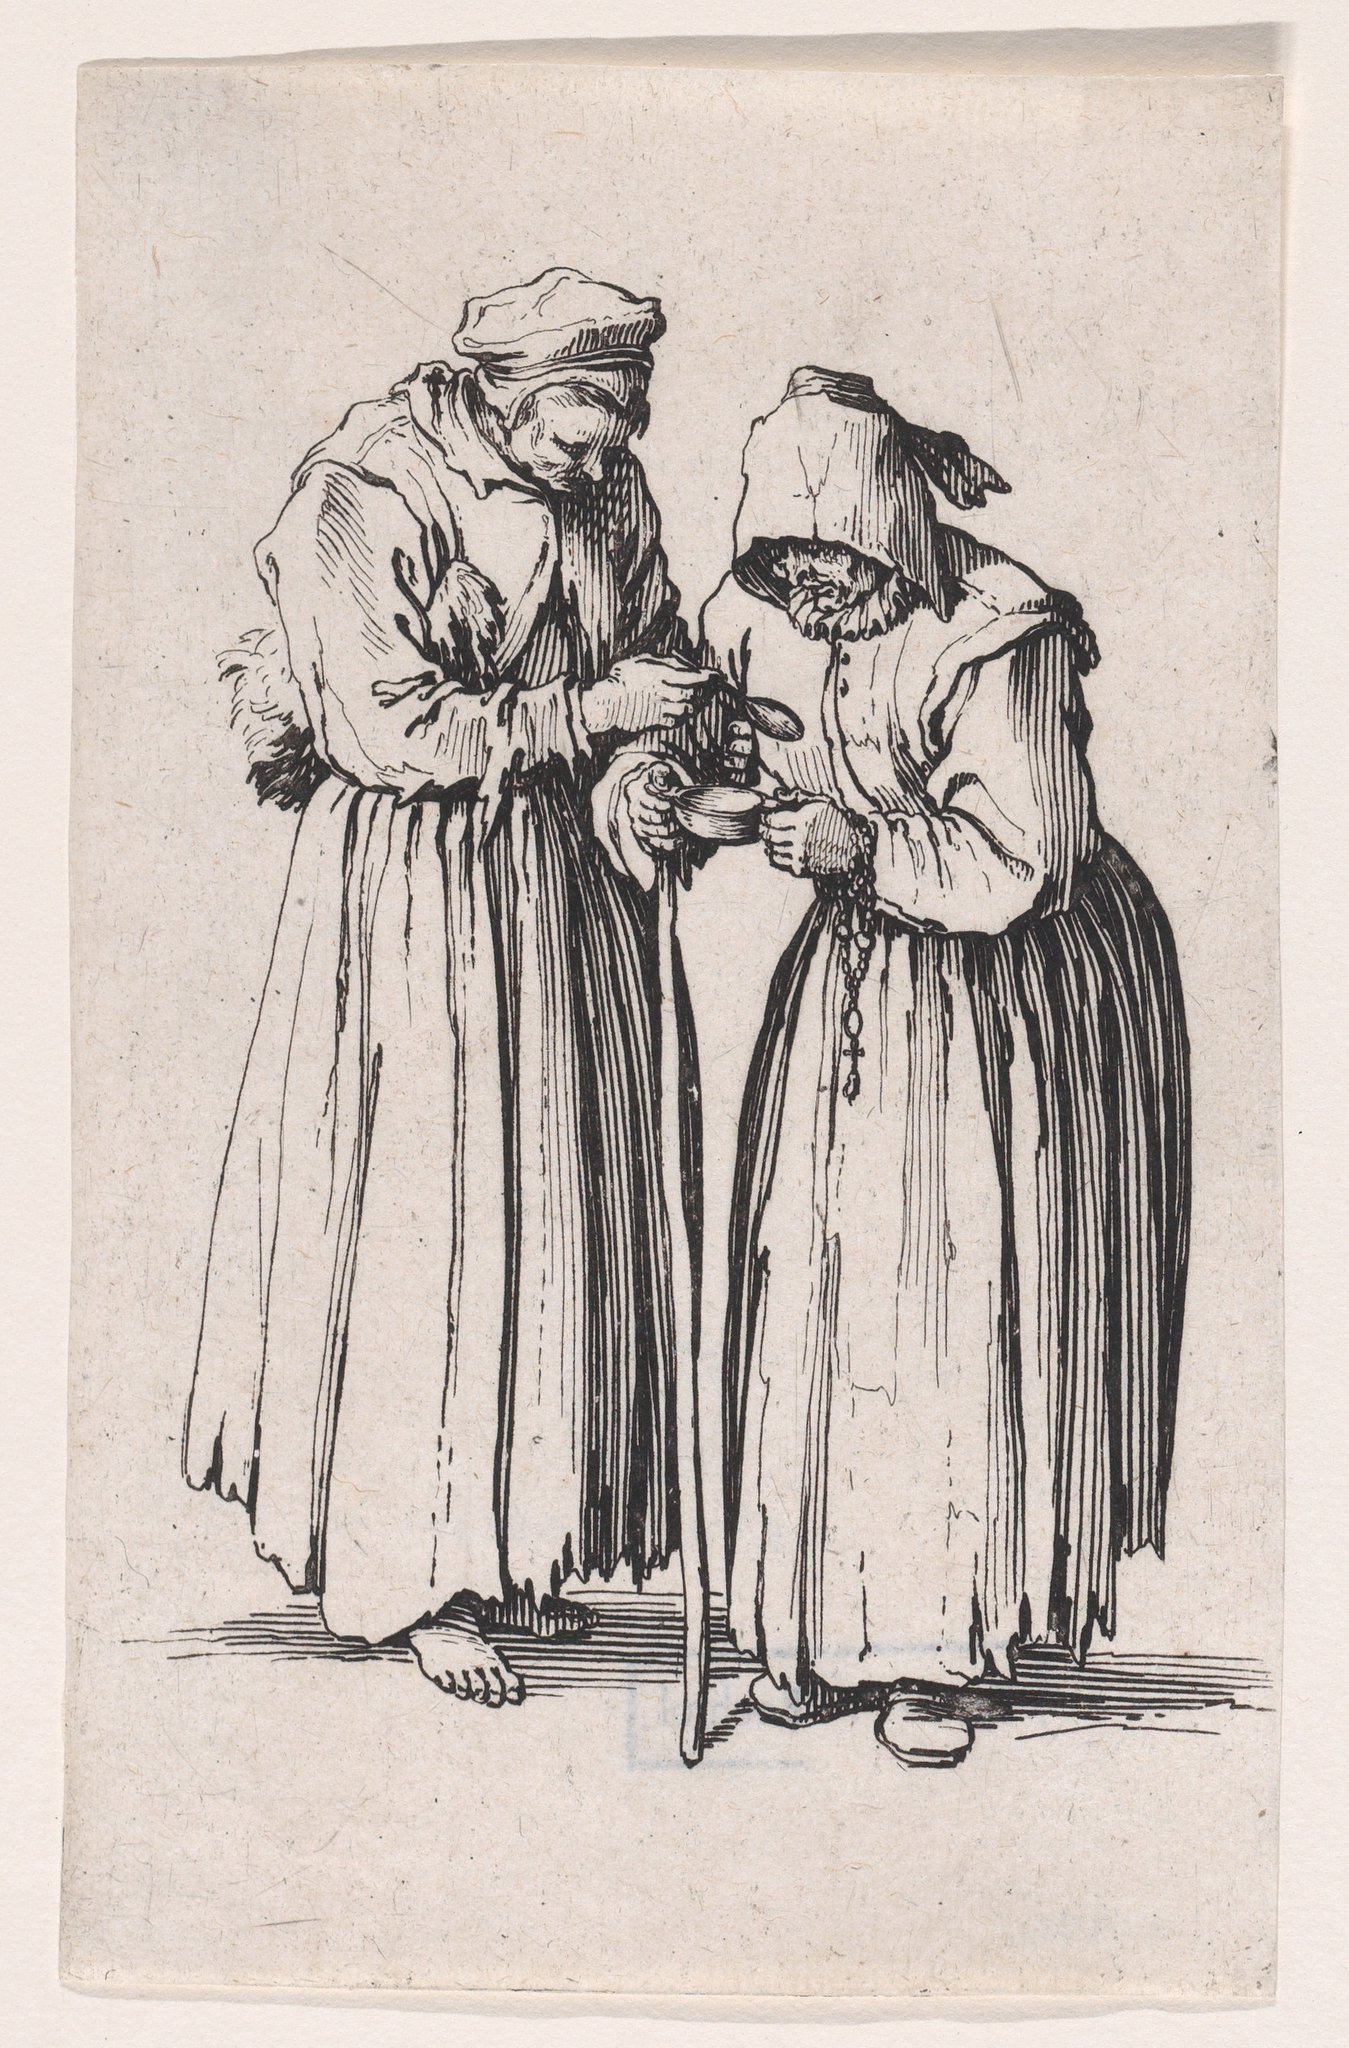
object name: print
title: Les Deux Mendiantes (The Two Female Beggars), from "Les Gueux suite appelée aussi Les Mendiants, Les Baroni, ou Les Barons" (The Beggars, also called the Barons)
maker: jacques callot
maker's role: artist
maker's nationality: french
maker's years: 1592-1635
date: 1623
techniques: etching